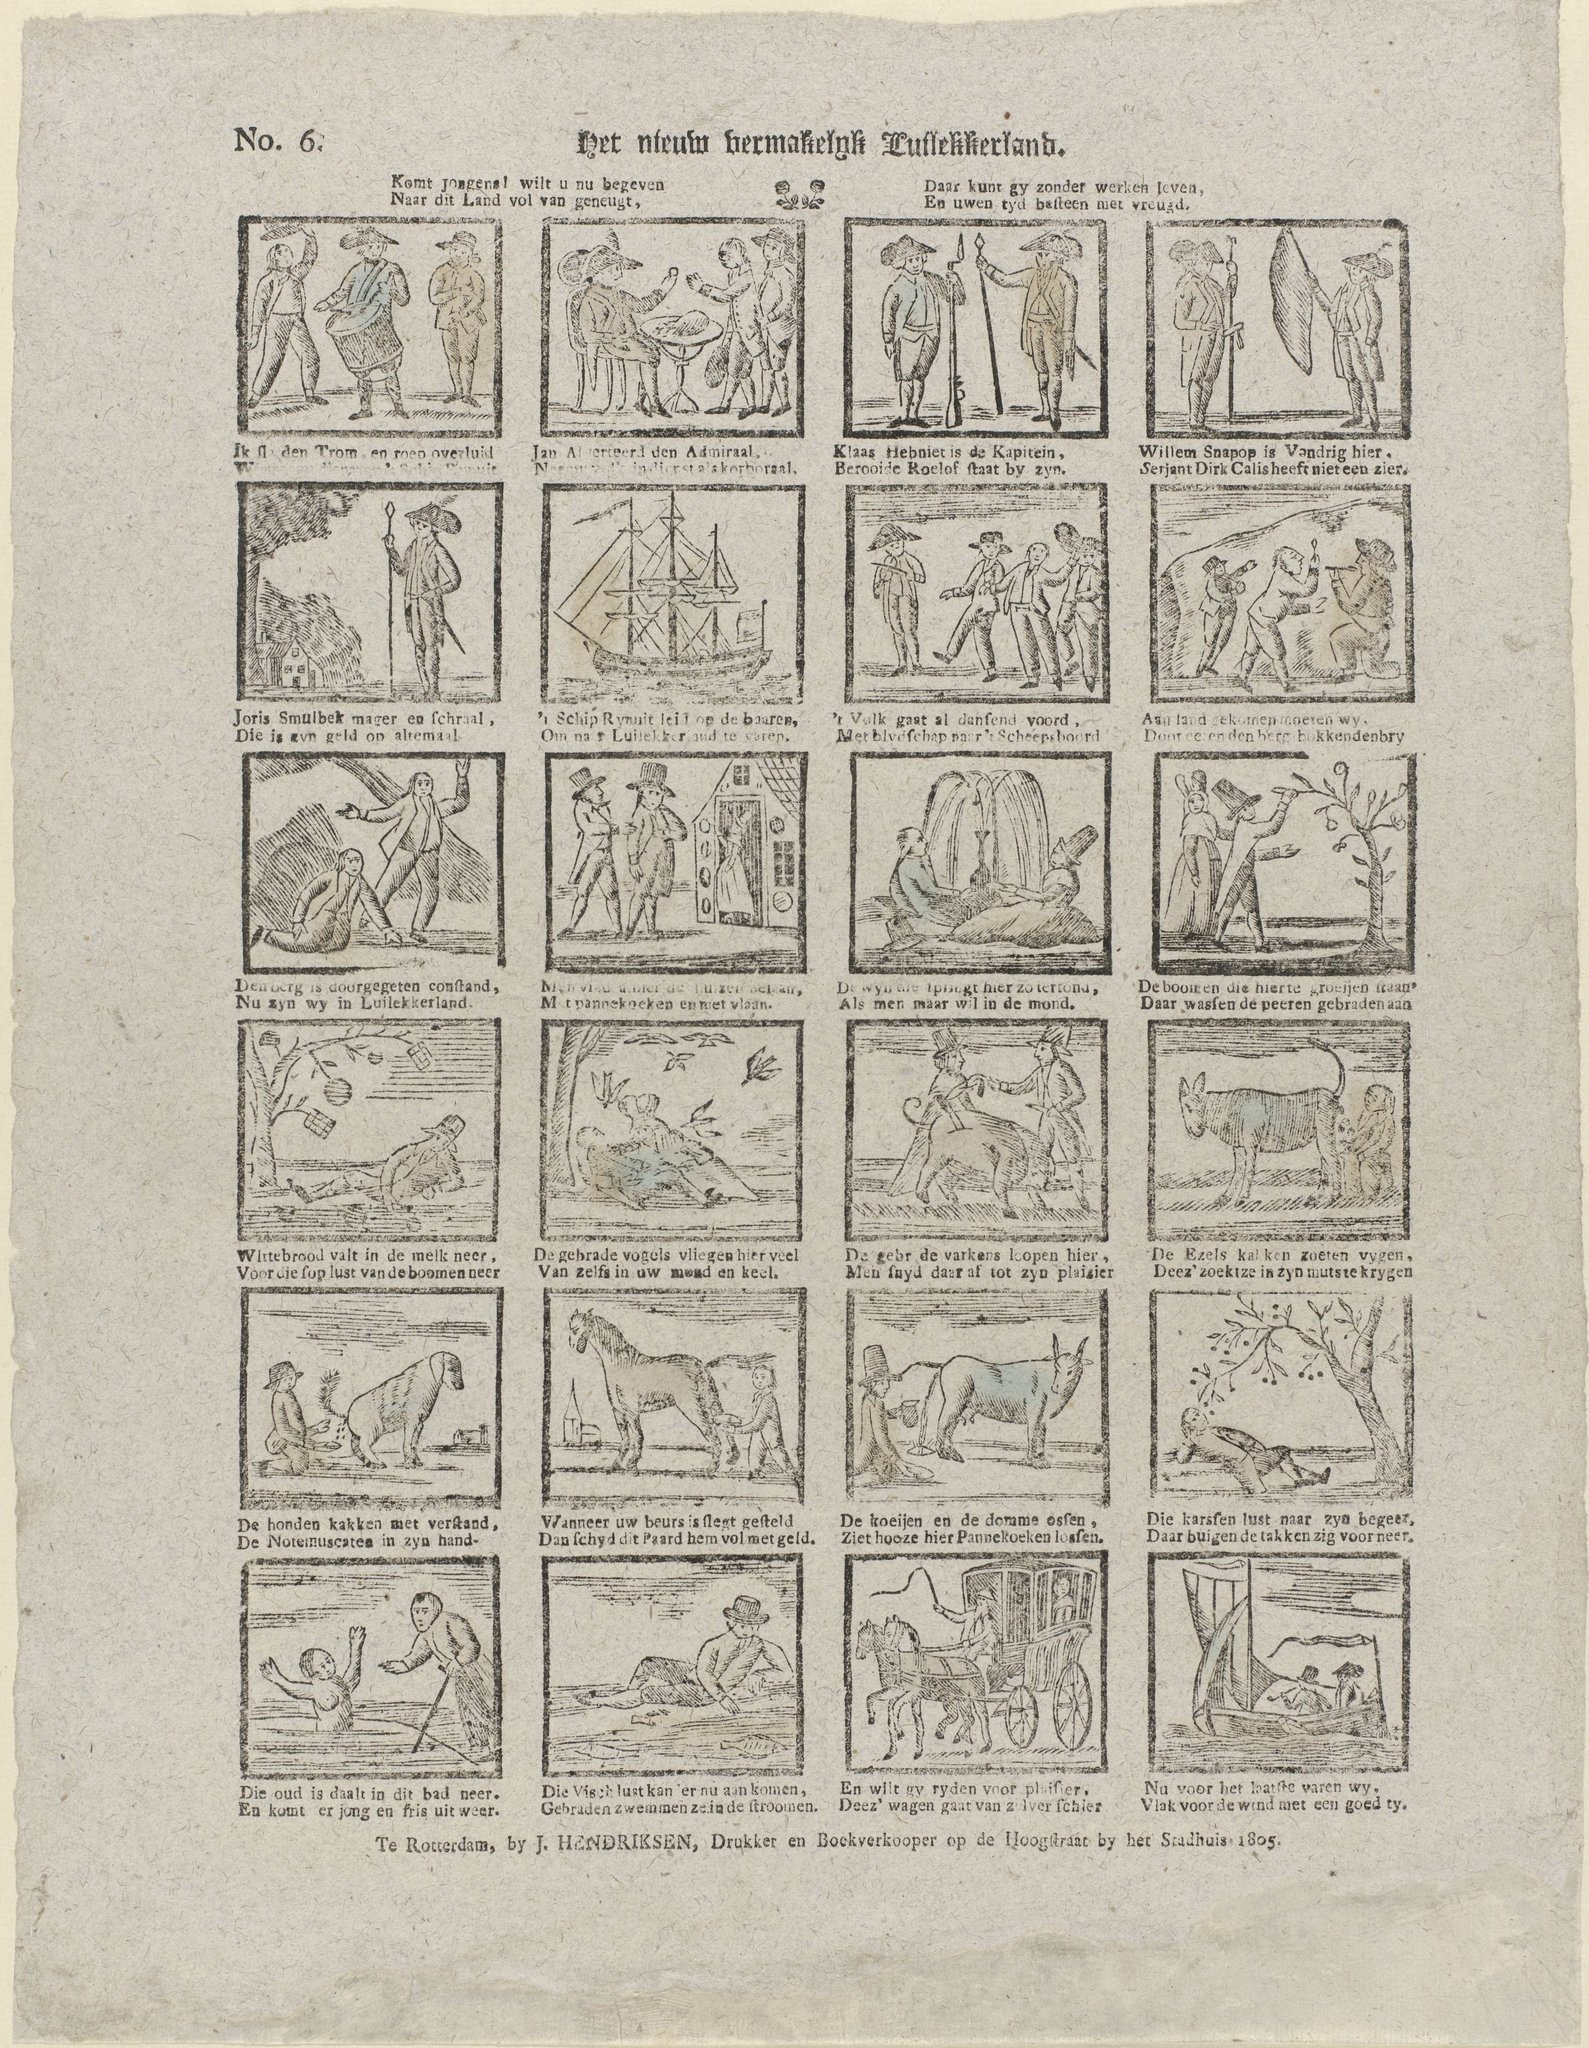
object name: print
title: Het Nieuw Vermakelyk Lui-Lekker-land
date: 1805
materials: paper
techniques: colour, letterpress printing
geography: rotterdam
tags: land of cockaigne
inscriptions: collector's mark: Lugt 2760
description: Blad met 24 voorstellingen van het Luilekkerland. Onder elke voorstelling een tweeregelig vers. Genummerd linksboven: No. 6.